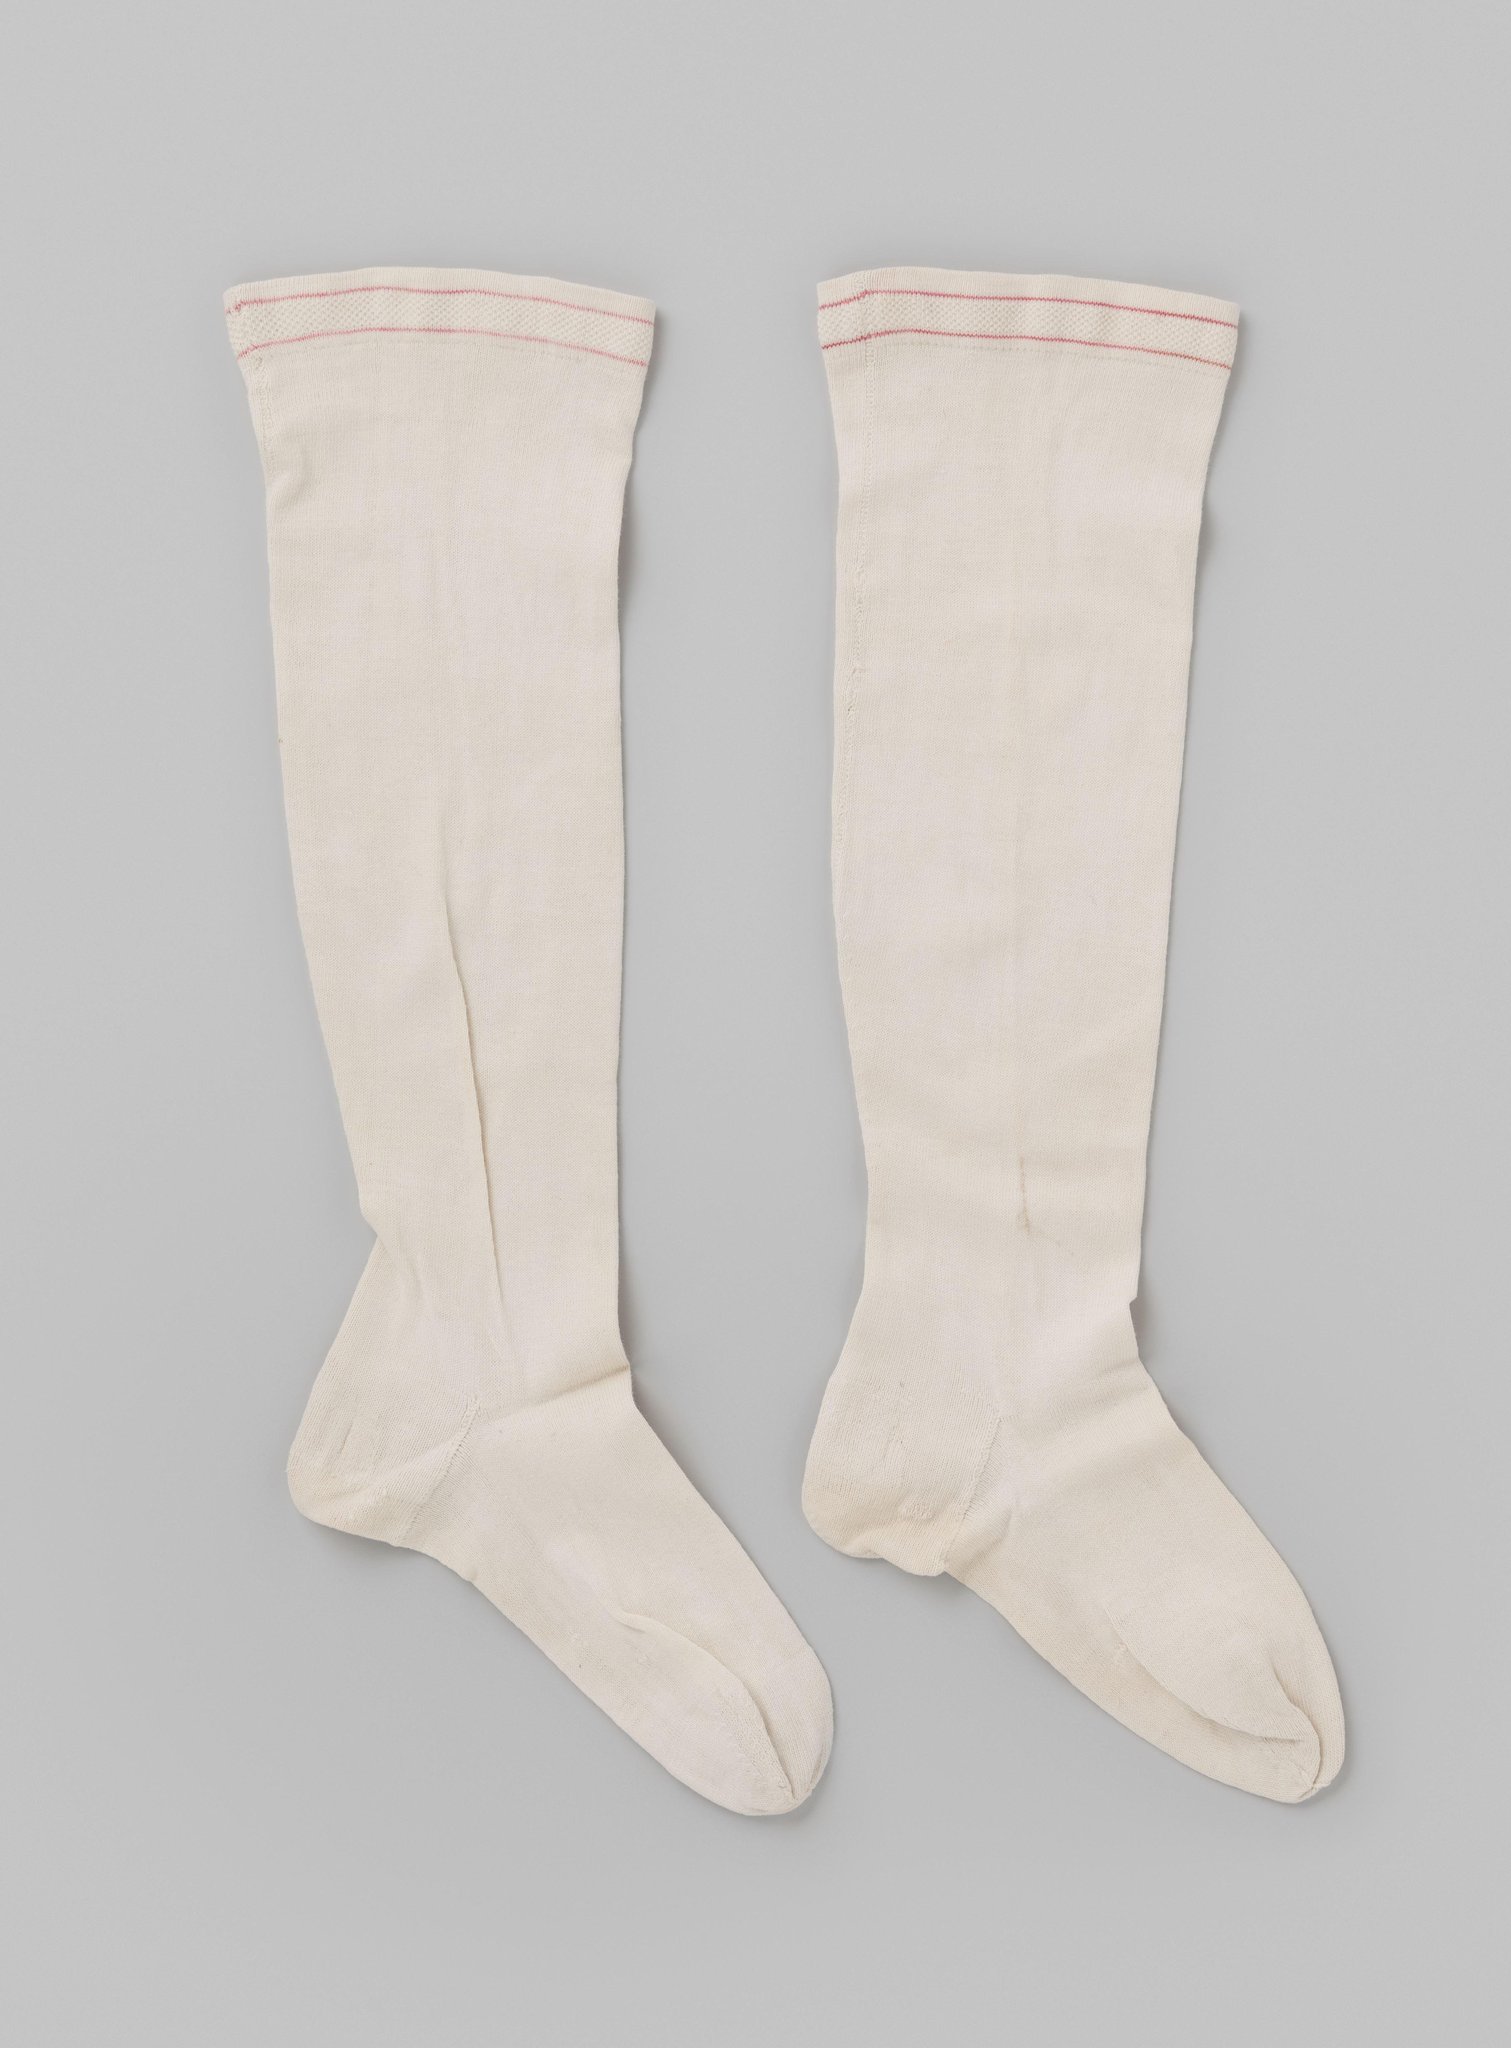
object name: stocking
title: Kous van effen witte katoenen tricot met in de boord twee rode strepen, waartussen een gerstekorrelsteek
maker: Anonymous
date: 1828-1830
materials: cotton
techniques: cross stitching, embroidered, knitting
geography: netherlands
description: Kous van effen witte katoenen tricot met in de boord twee rode strepen, waartussen een gerstekorrelsteek.